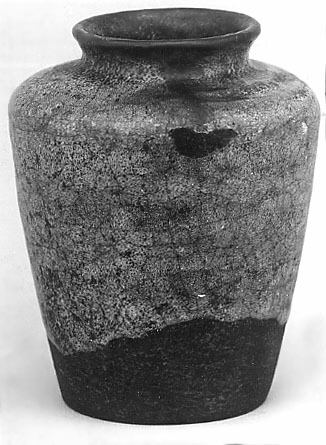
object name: tea jar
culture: japanese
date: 1801-1900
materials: clay, glaze